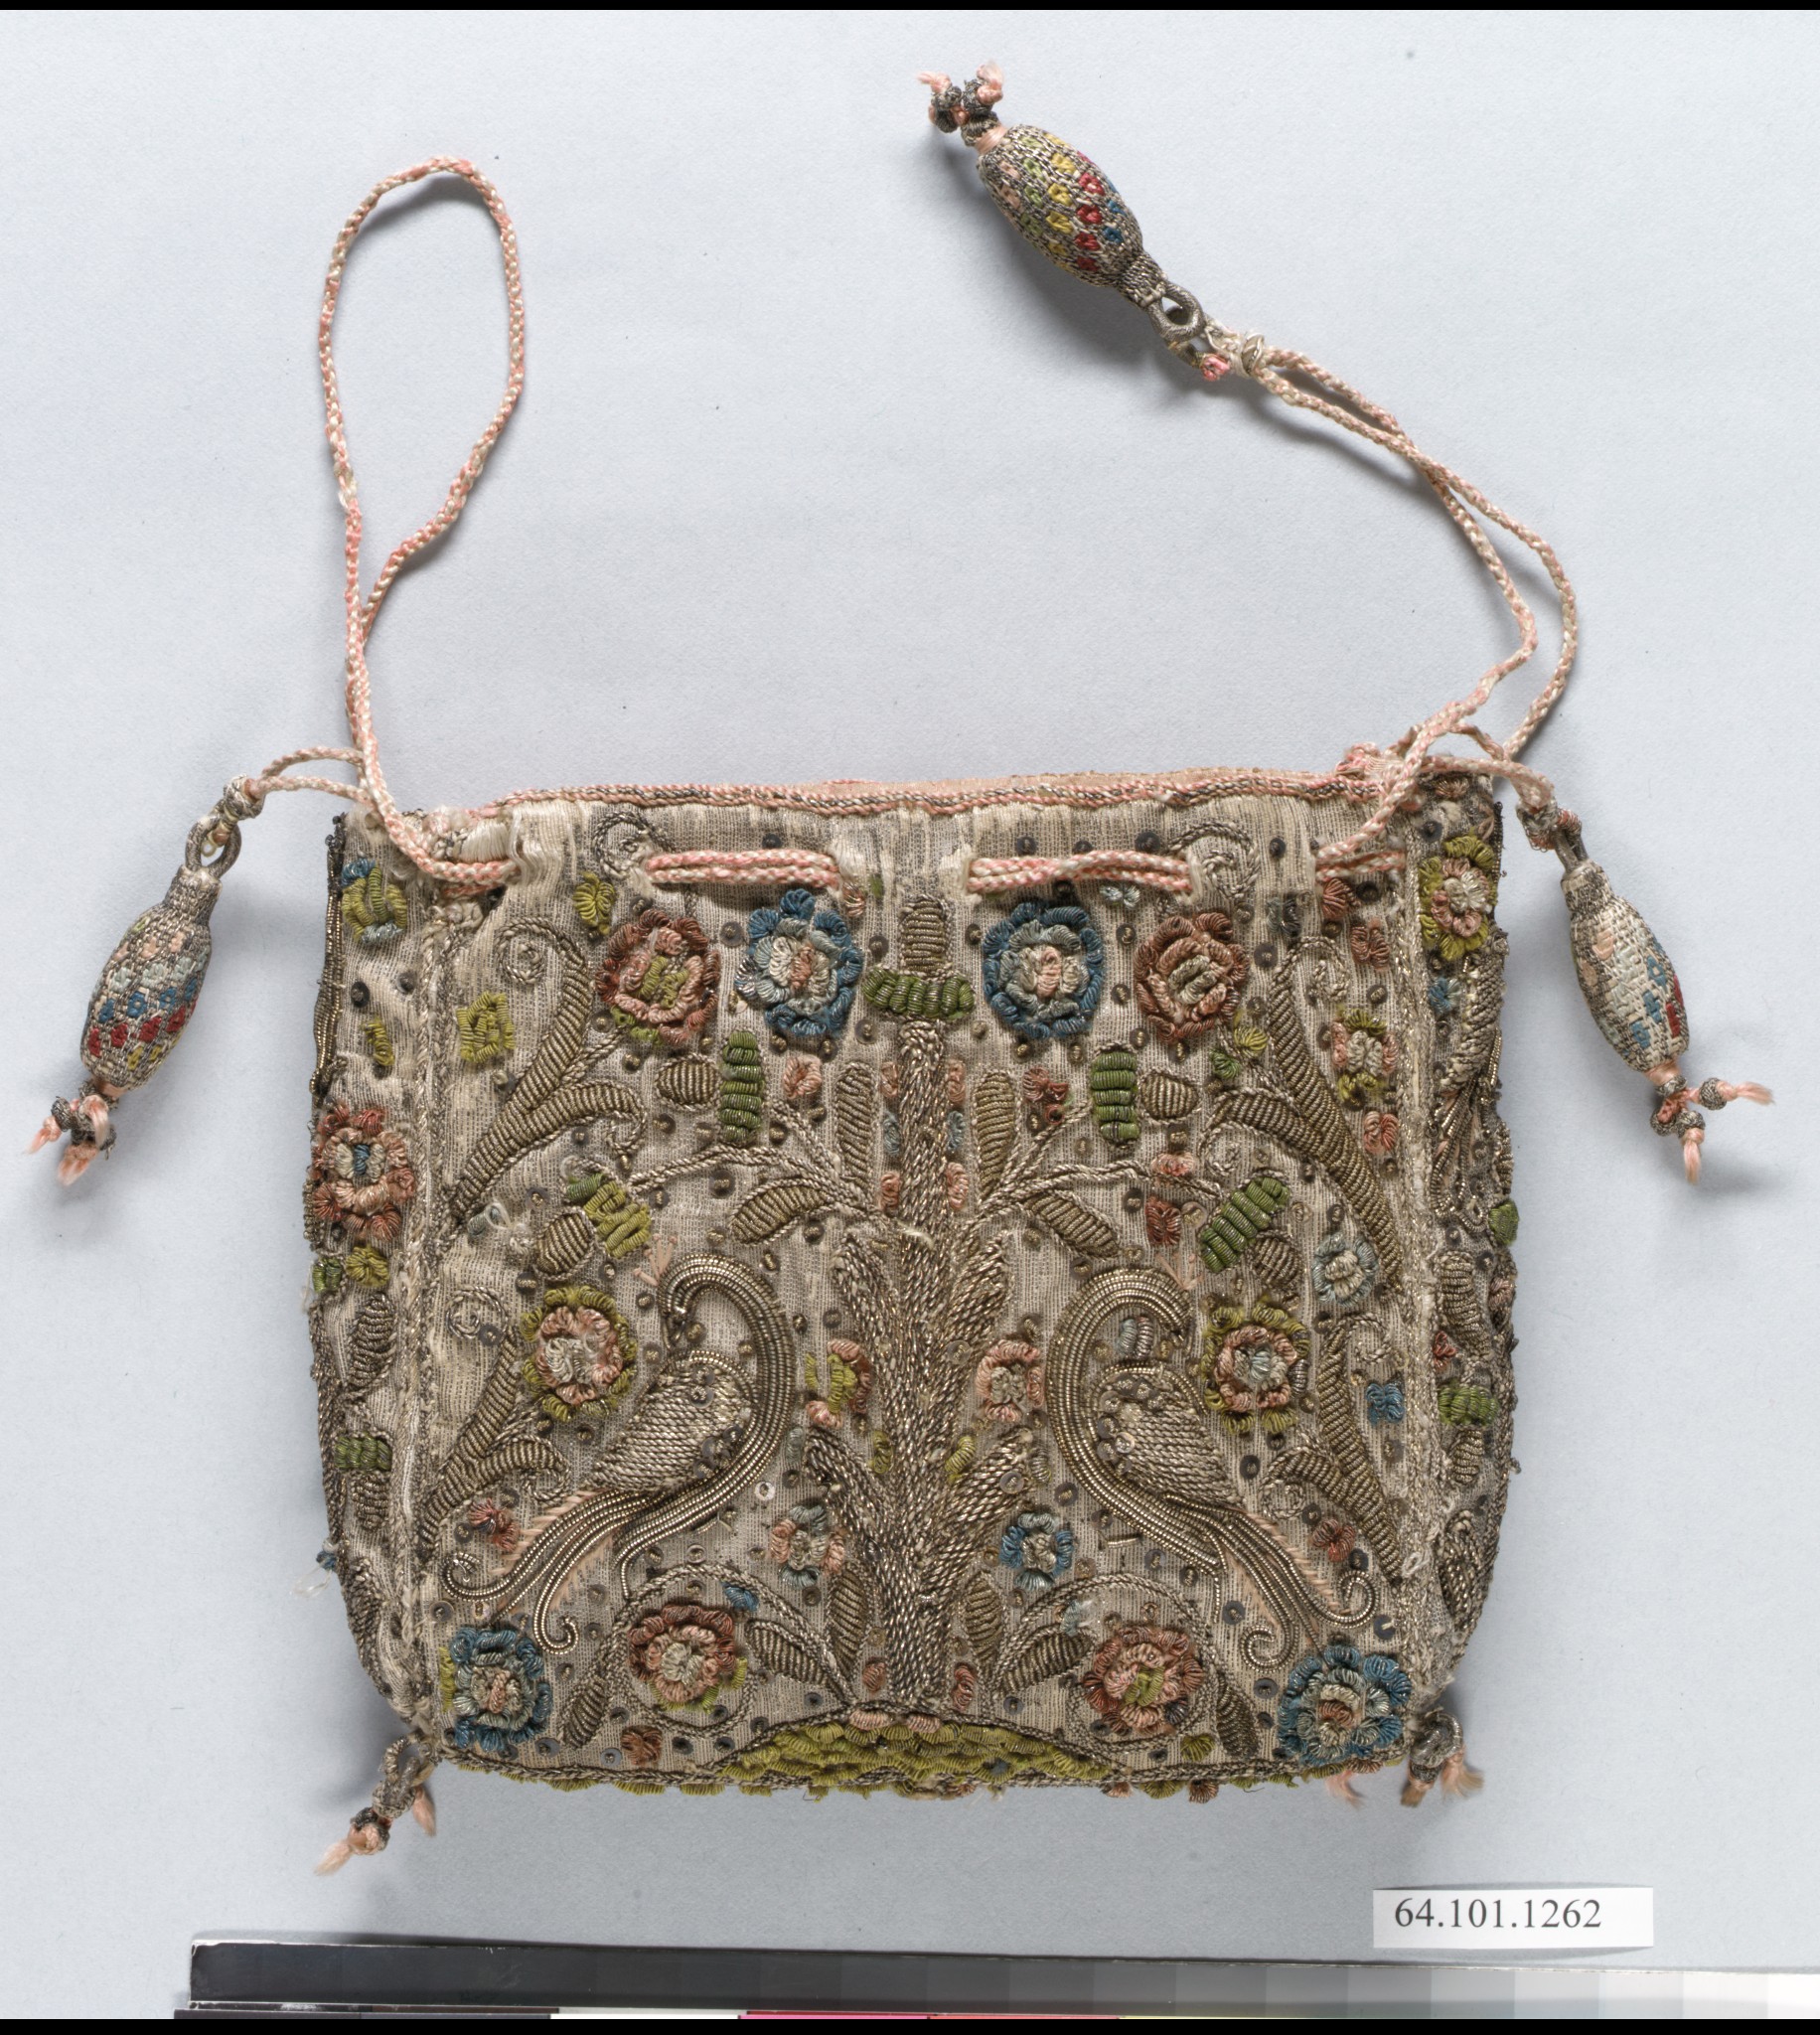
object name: purse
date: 1601-1625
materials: canvas, metal thread, silk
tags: flowers